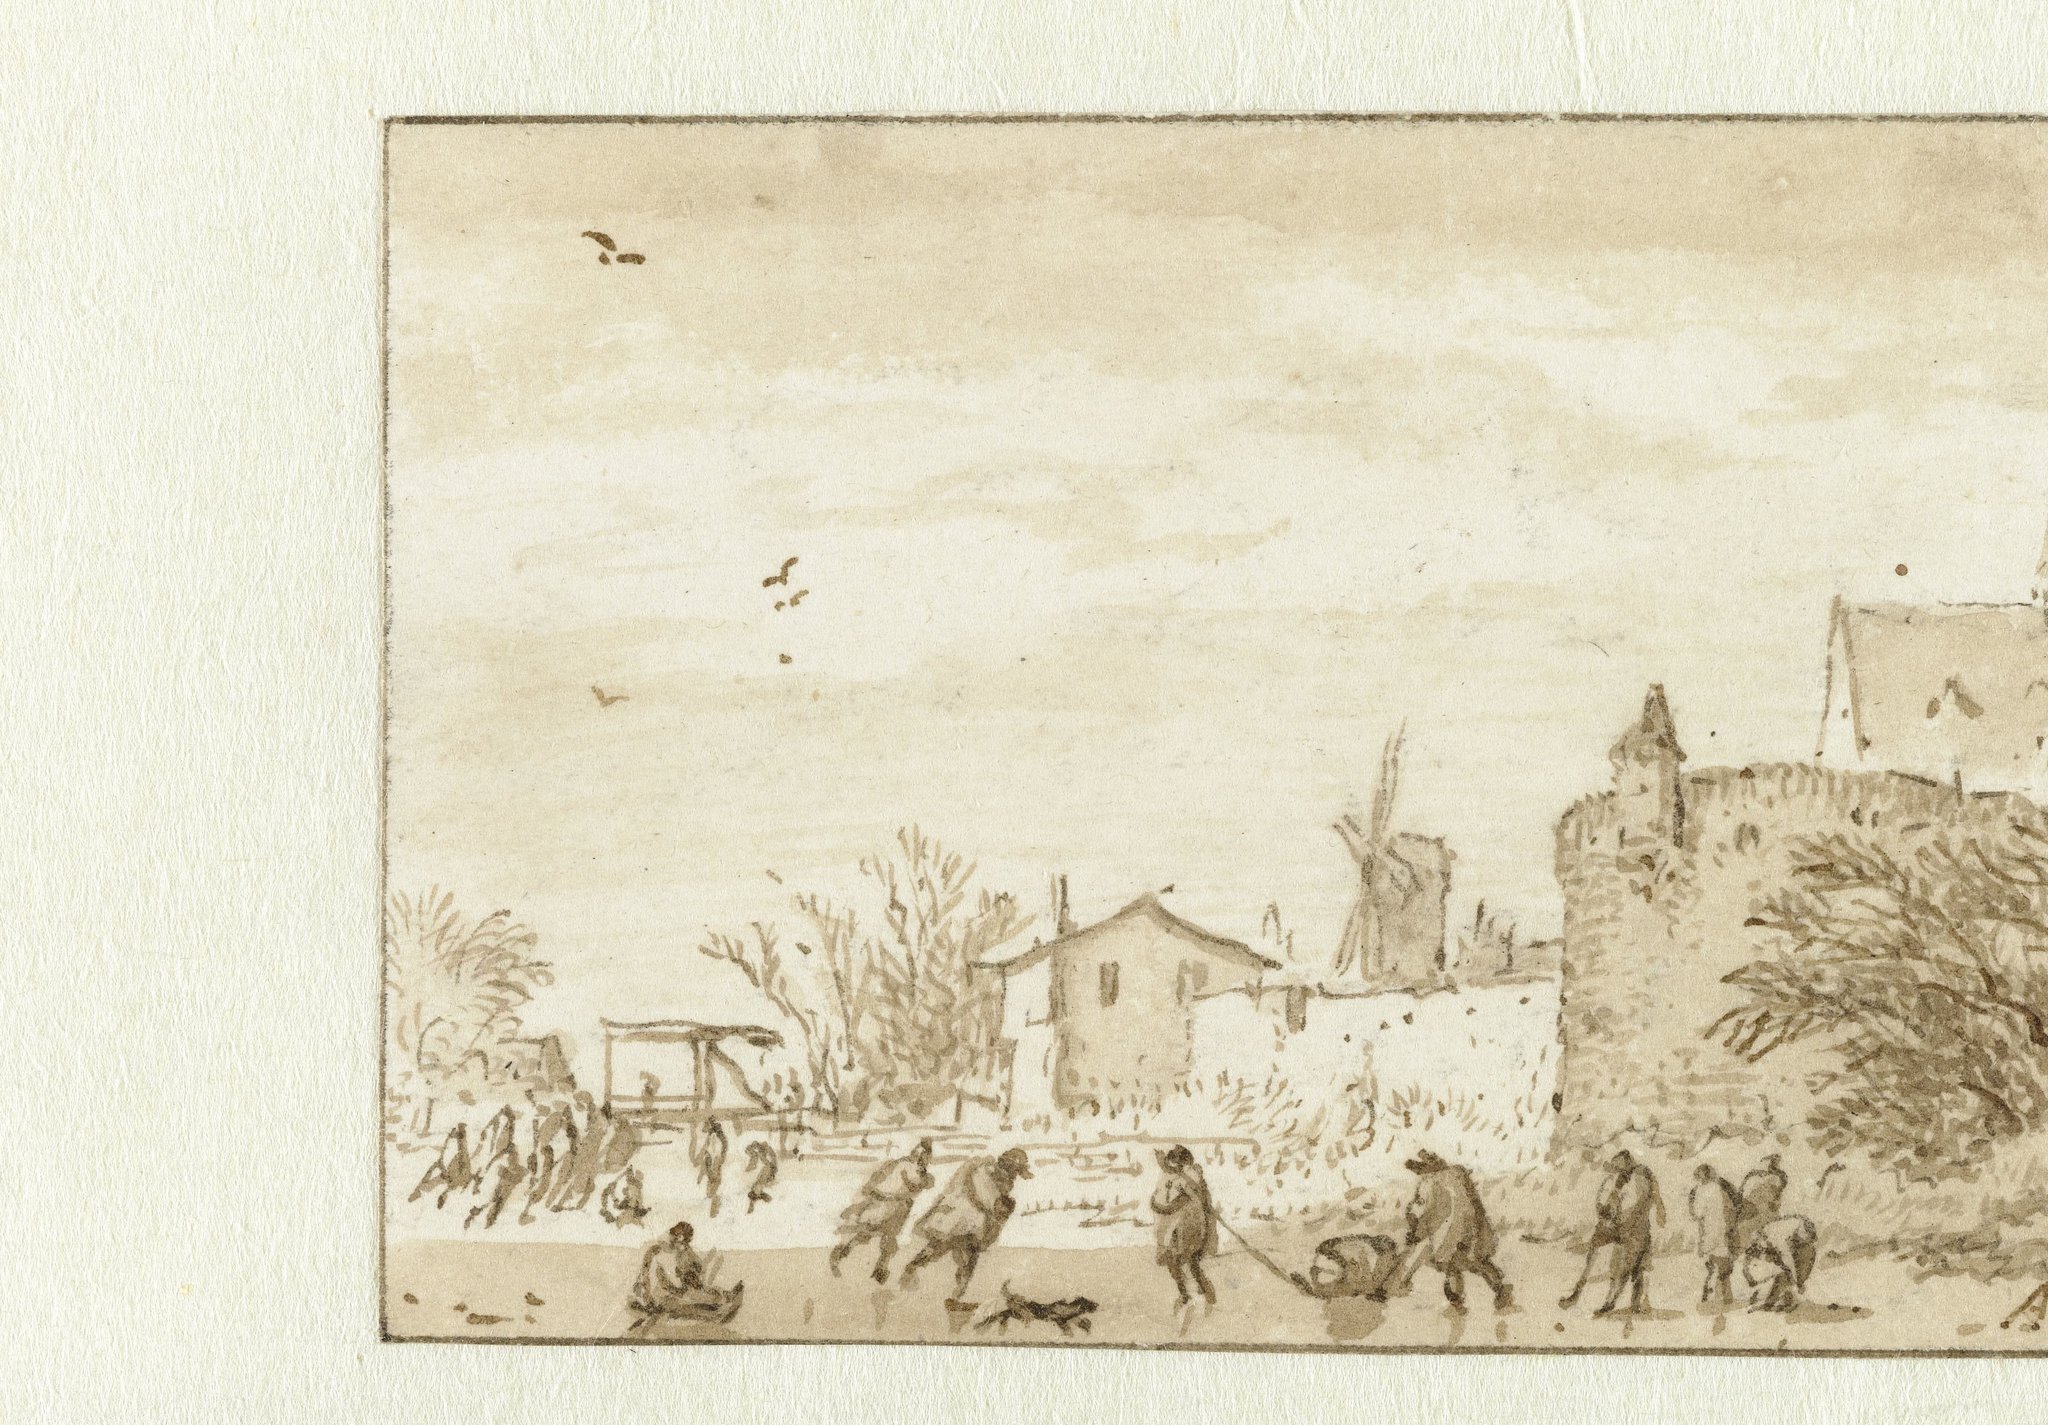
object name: drawing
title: Winterlandschap met ijsvermaak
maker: allaert van everdingen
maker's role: draughtsman, painter, print maker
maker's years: 1621-1675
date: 1631-1675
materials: ink, paper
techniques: brush, pen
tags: winter sports